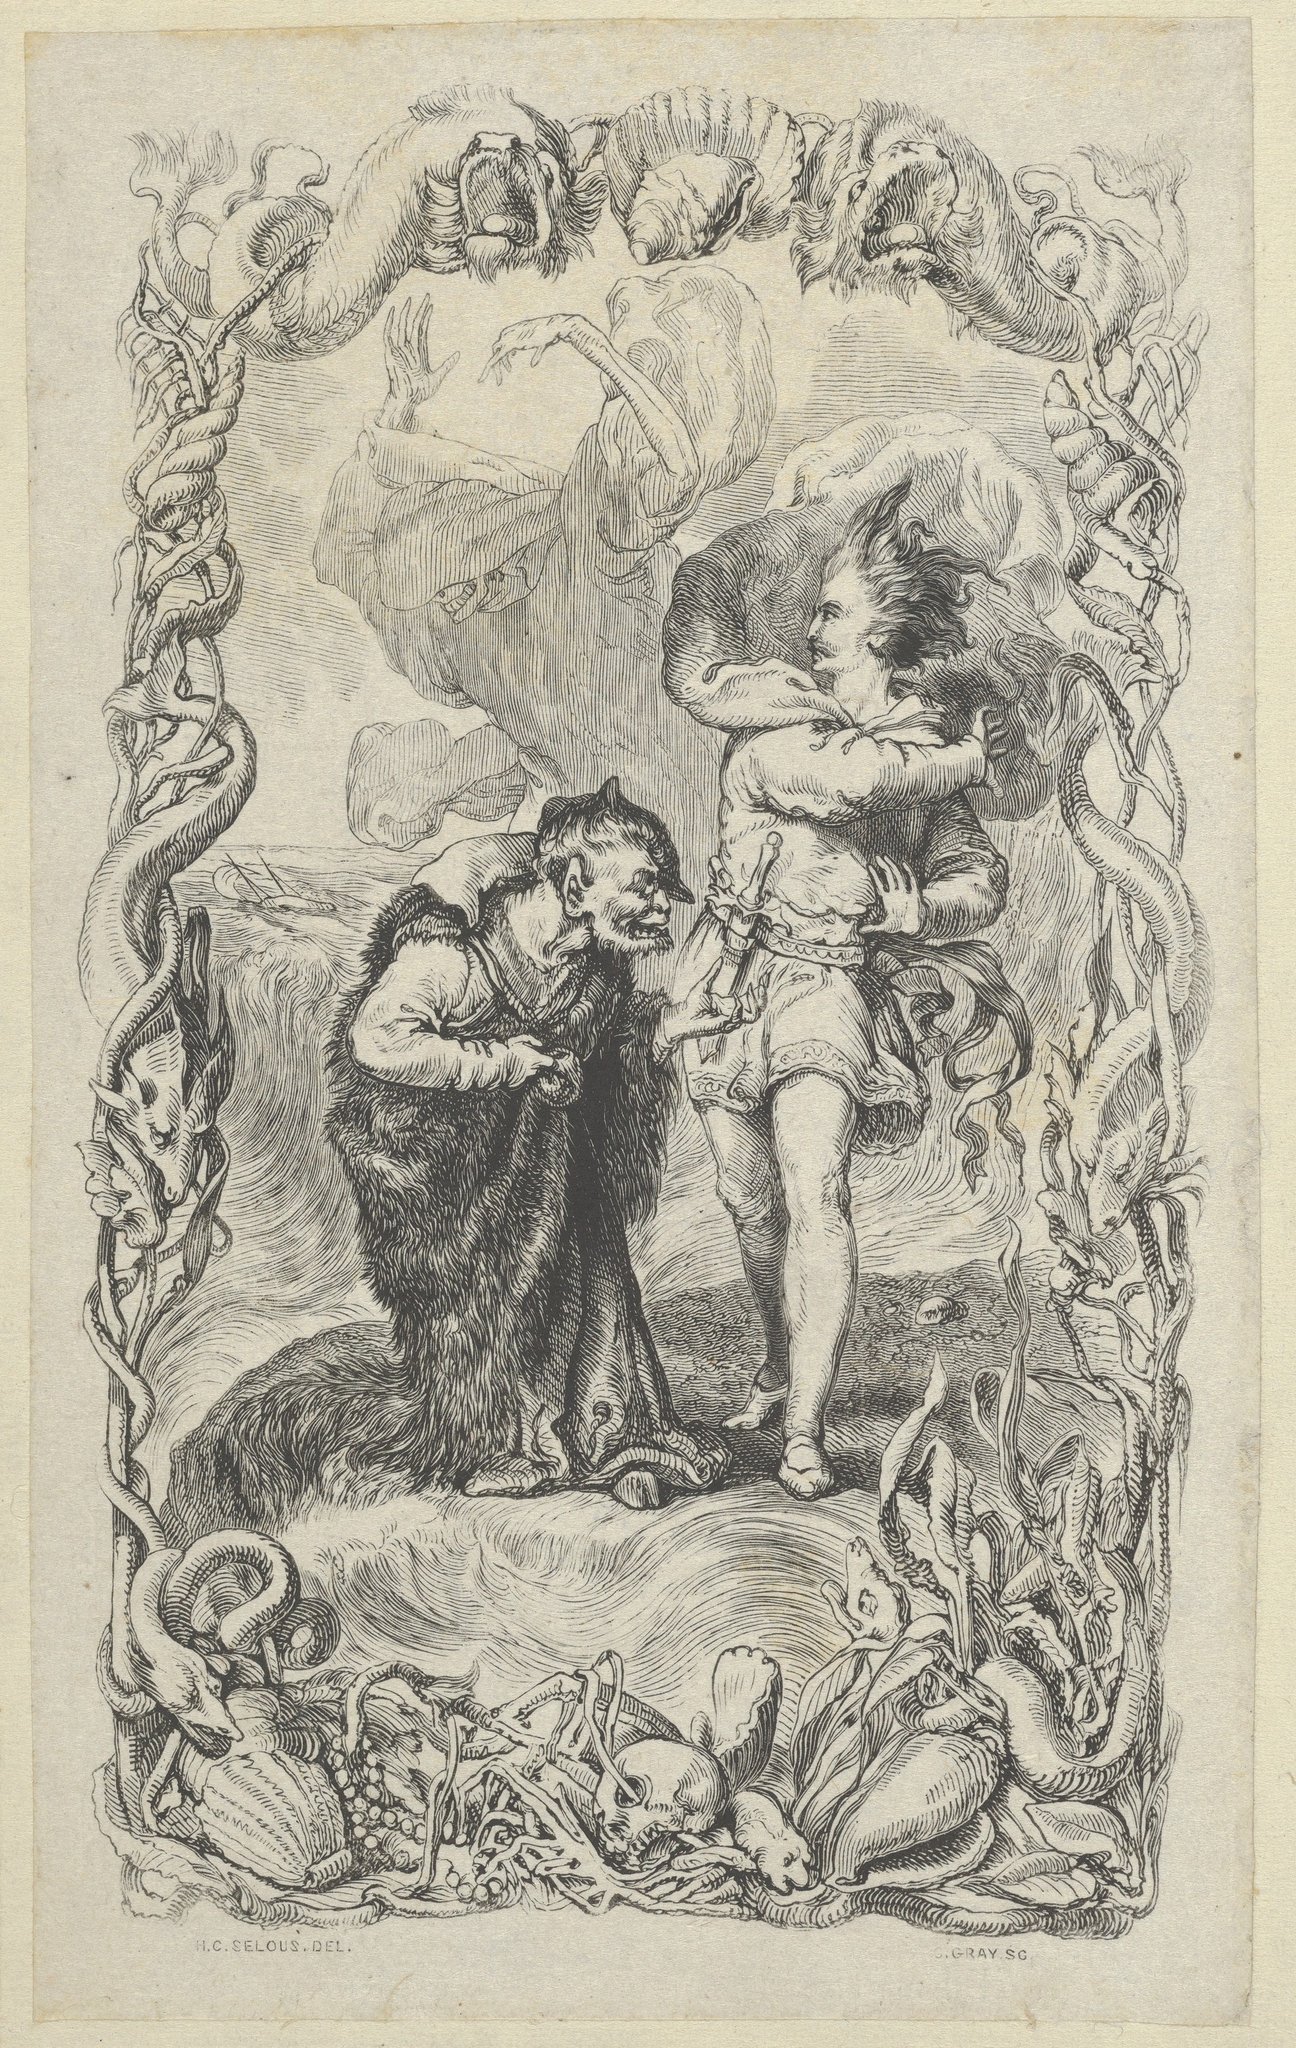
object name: print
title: Illustration to the Tempest: Caliban, Ferdinand and Ariel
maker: charles gray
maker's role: etcher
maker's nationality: british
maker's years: 1747-1845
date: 1836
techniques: etching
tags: shakespeare,men